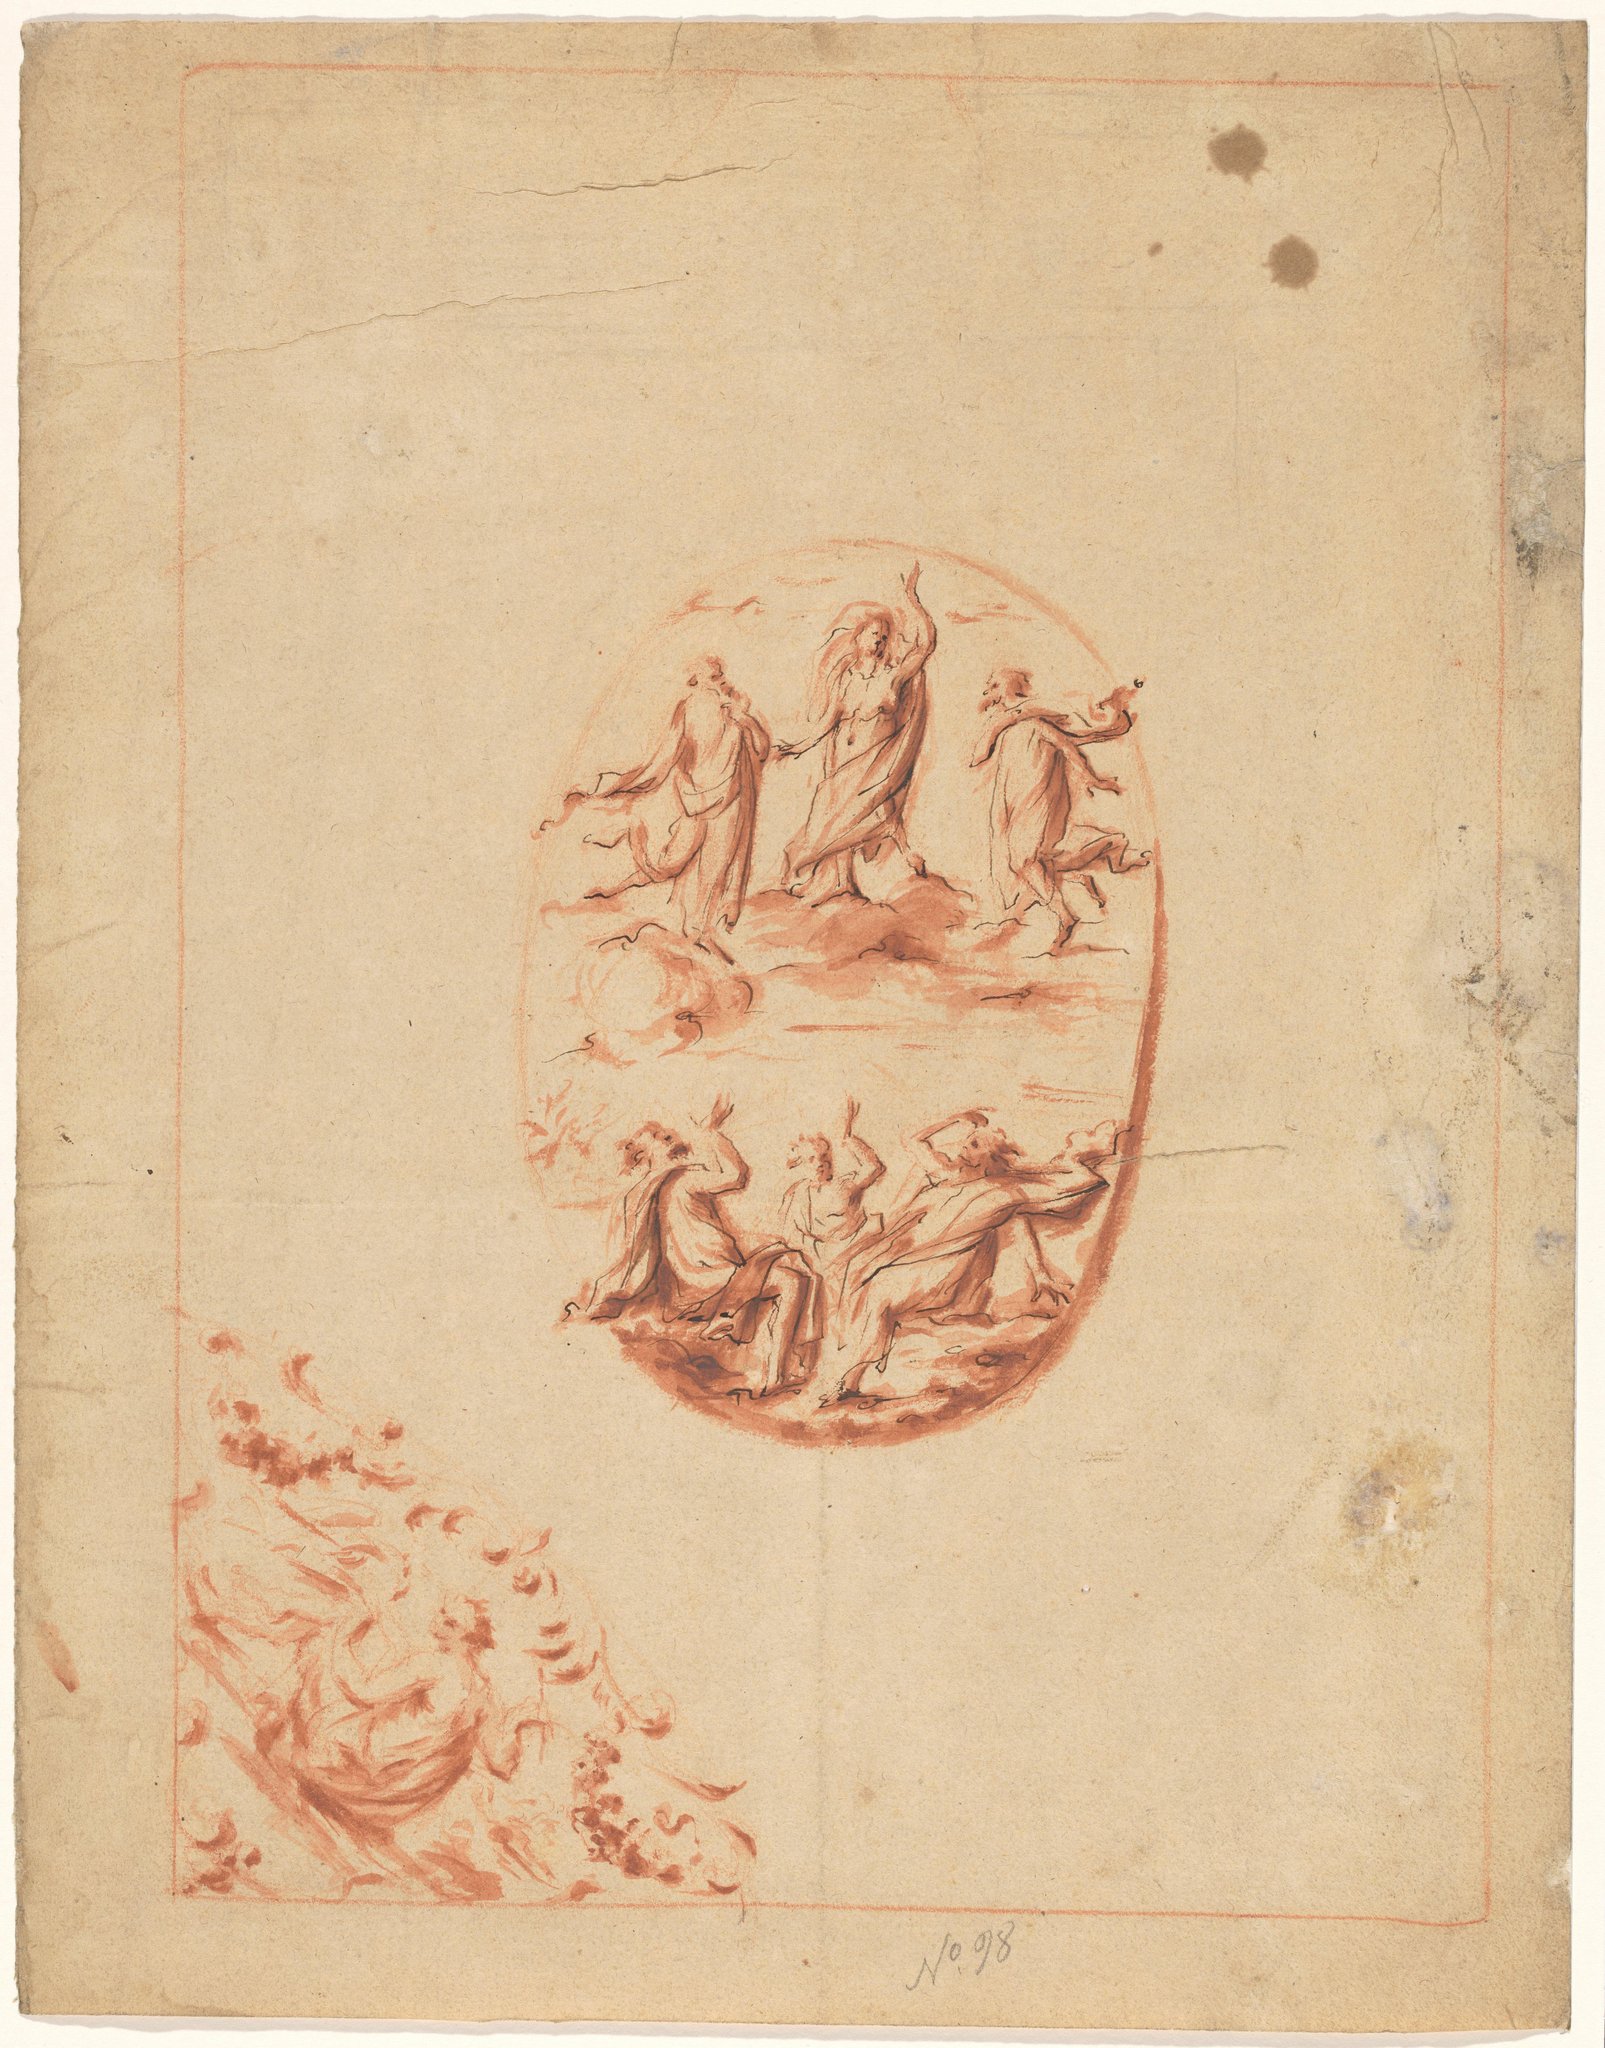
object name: design drawing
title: Ontwerp voor het beslag van een boekdeksel, met de hemelvaart van Christus en de evangelist Johannes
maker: Anonymous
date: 1650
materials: chalk, ink, paper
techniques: brush, pen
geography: paris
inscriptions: number: ‘No 98’, watermark